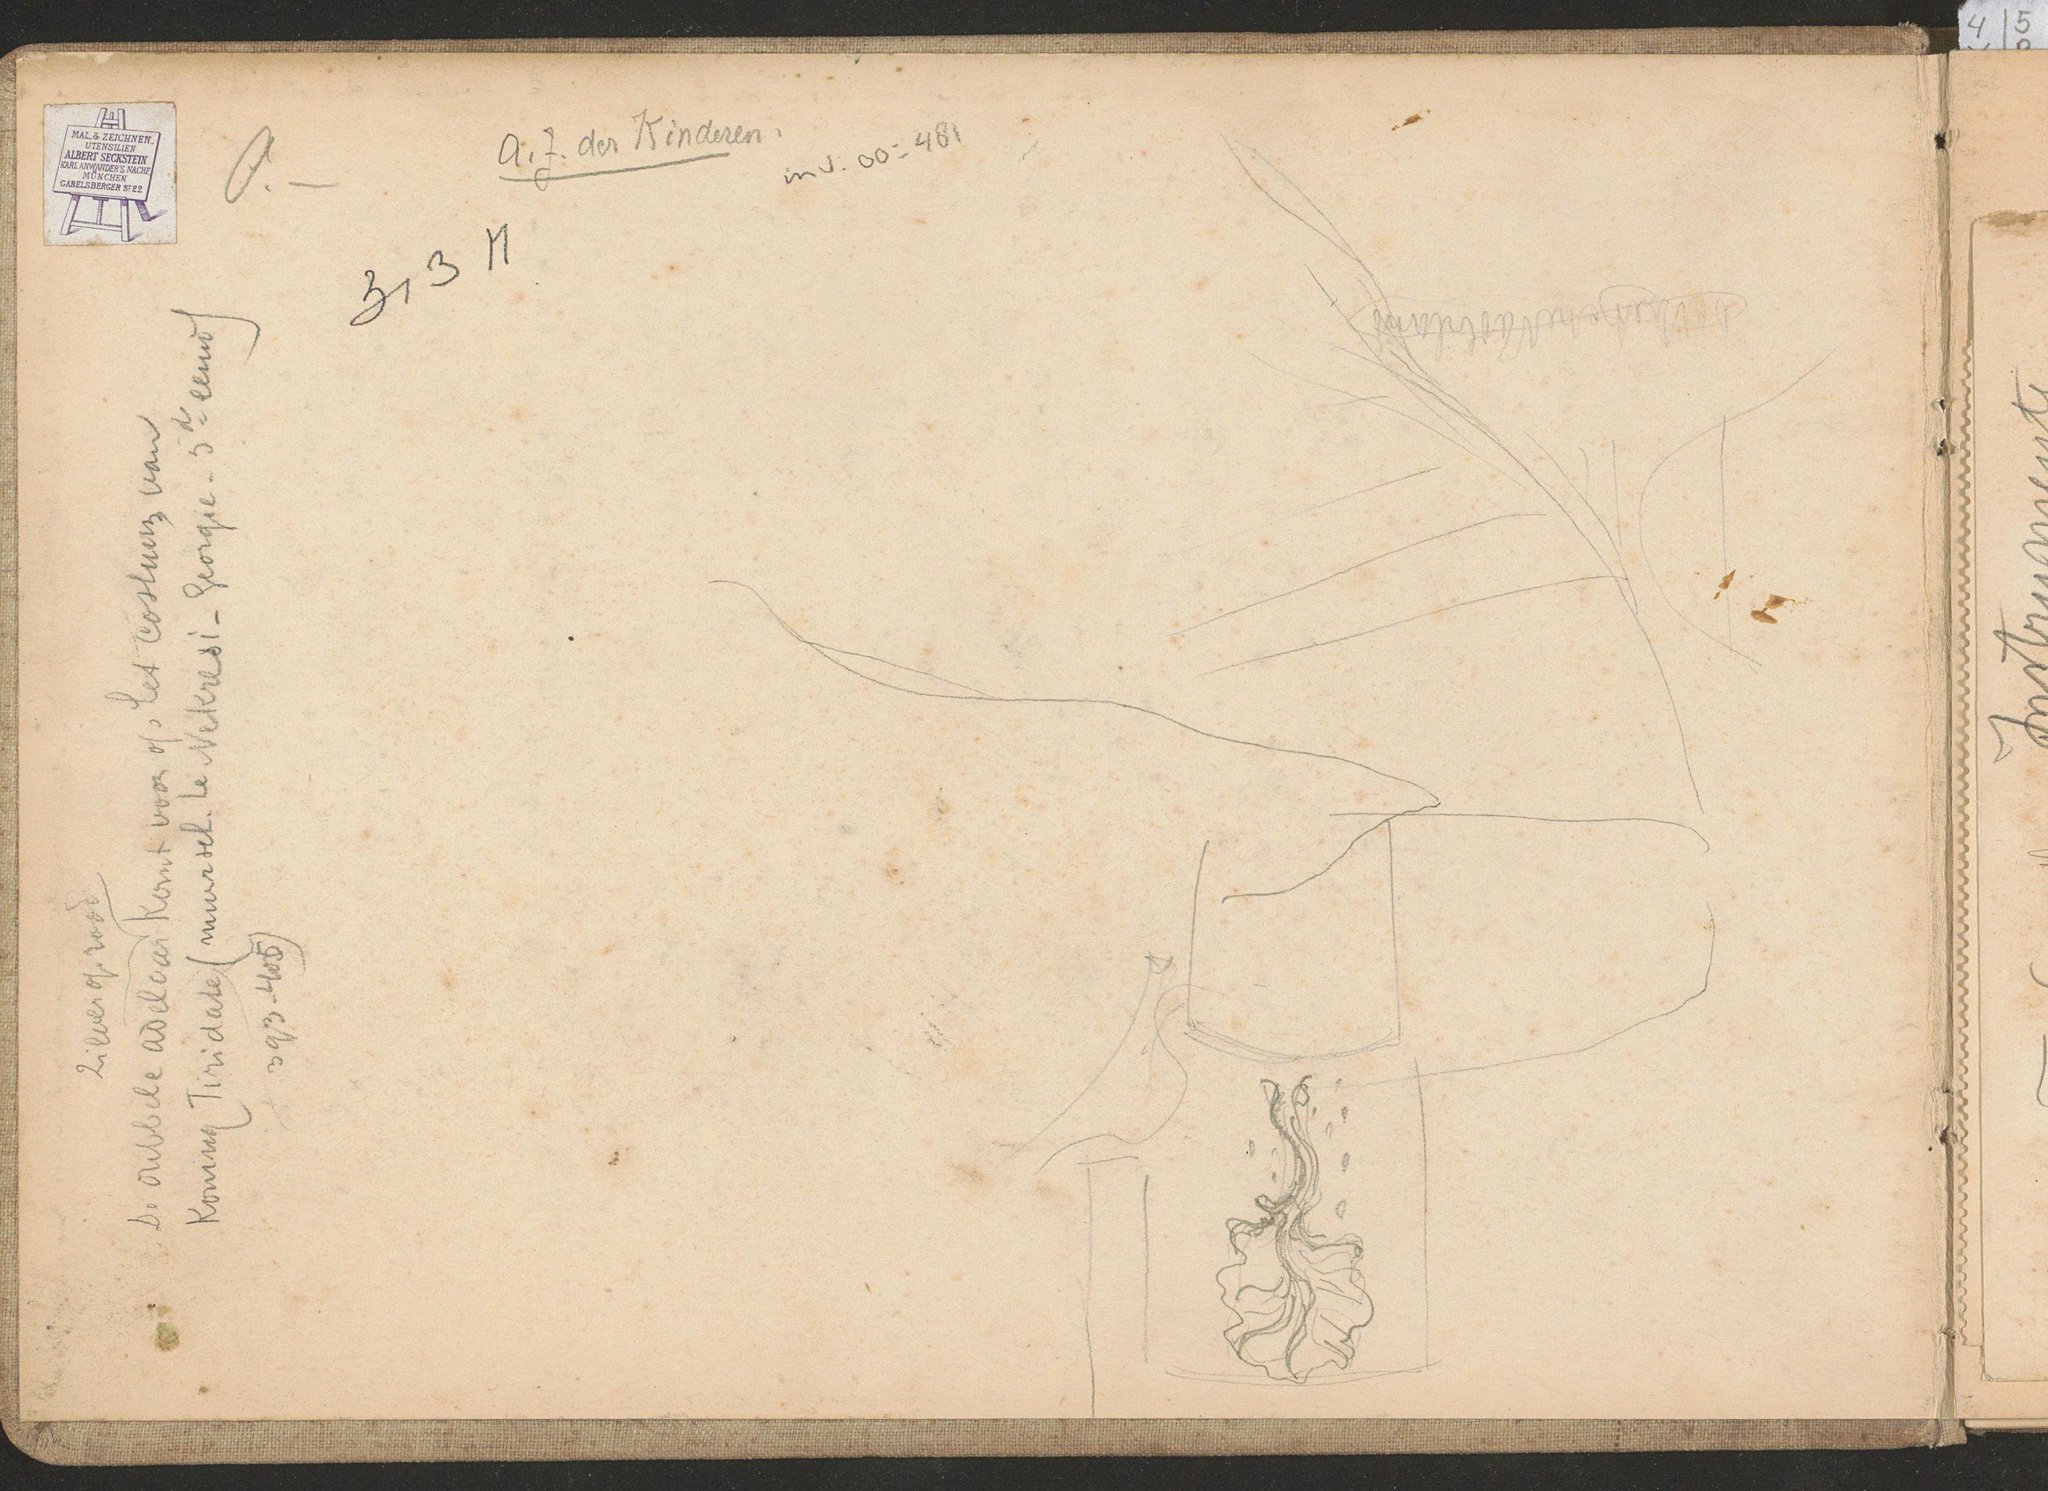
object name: sketchbook leaf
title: Studie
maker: antoon derkinderen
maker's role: draughtsman, painter, print maker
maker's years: 1859-1925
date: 1869-1925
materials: paper, pencil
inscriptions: annotation: ‘De dubbele adelaar zilver op rood komt voor op het costuum van/ koning Tiridates [...] - Georie - 5de eeuw/ 393-405/ [...]’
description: Mogelijk een blad. Voorste schutblad uit een schetsboek met 28 bladen.